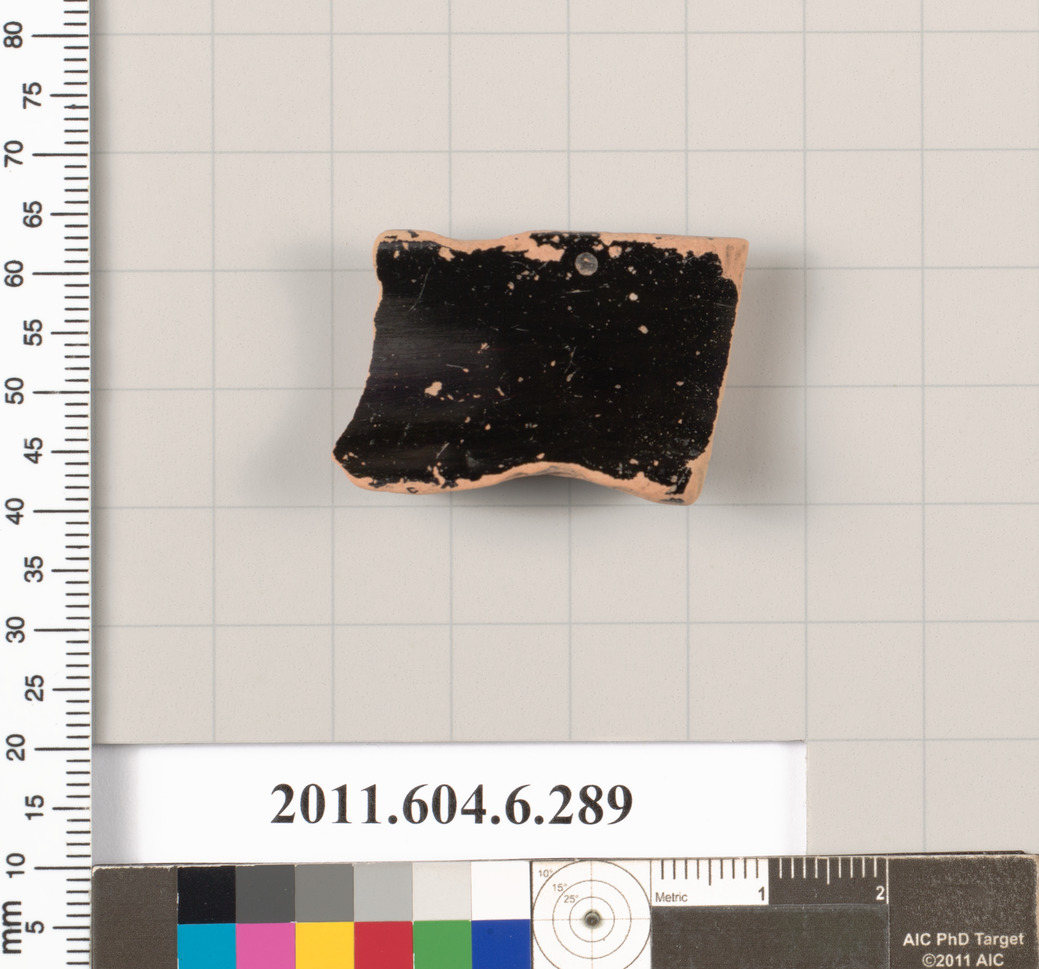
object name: kalathos fragment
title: Terracotta rim fragment of a kalathos?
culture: greek, attic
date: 534-468 BCE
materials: terracotta